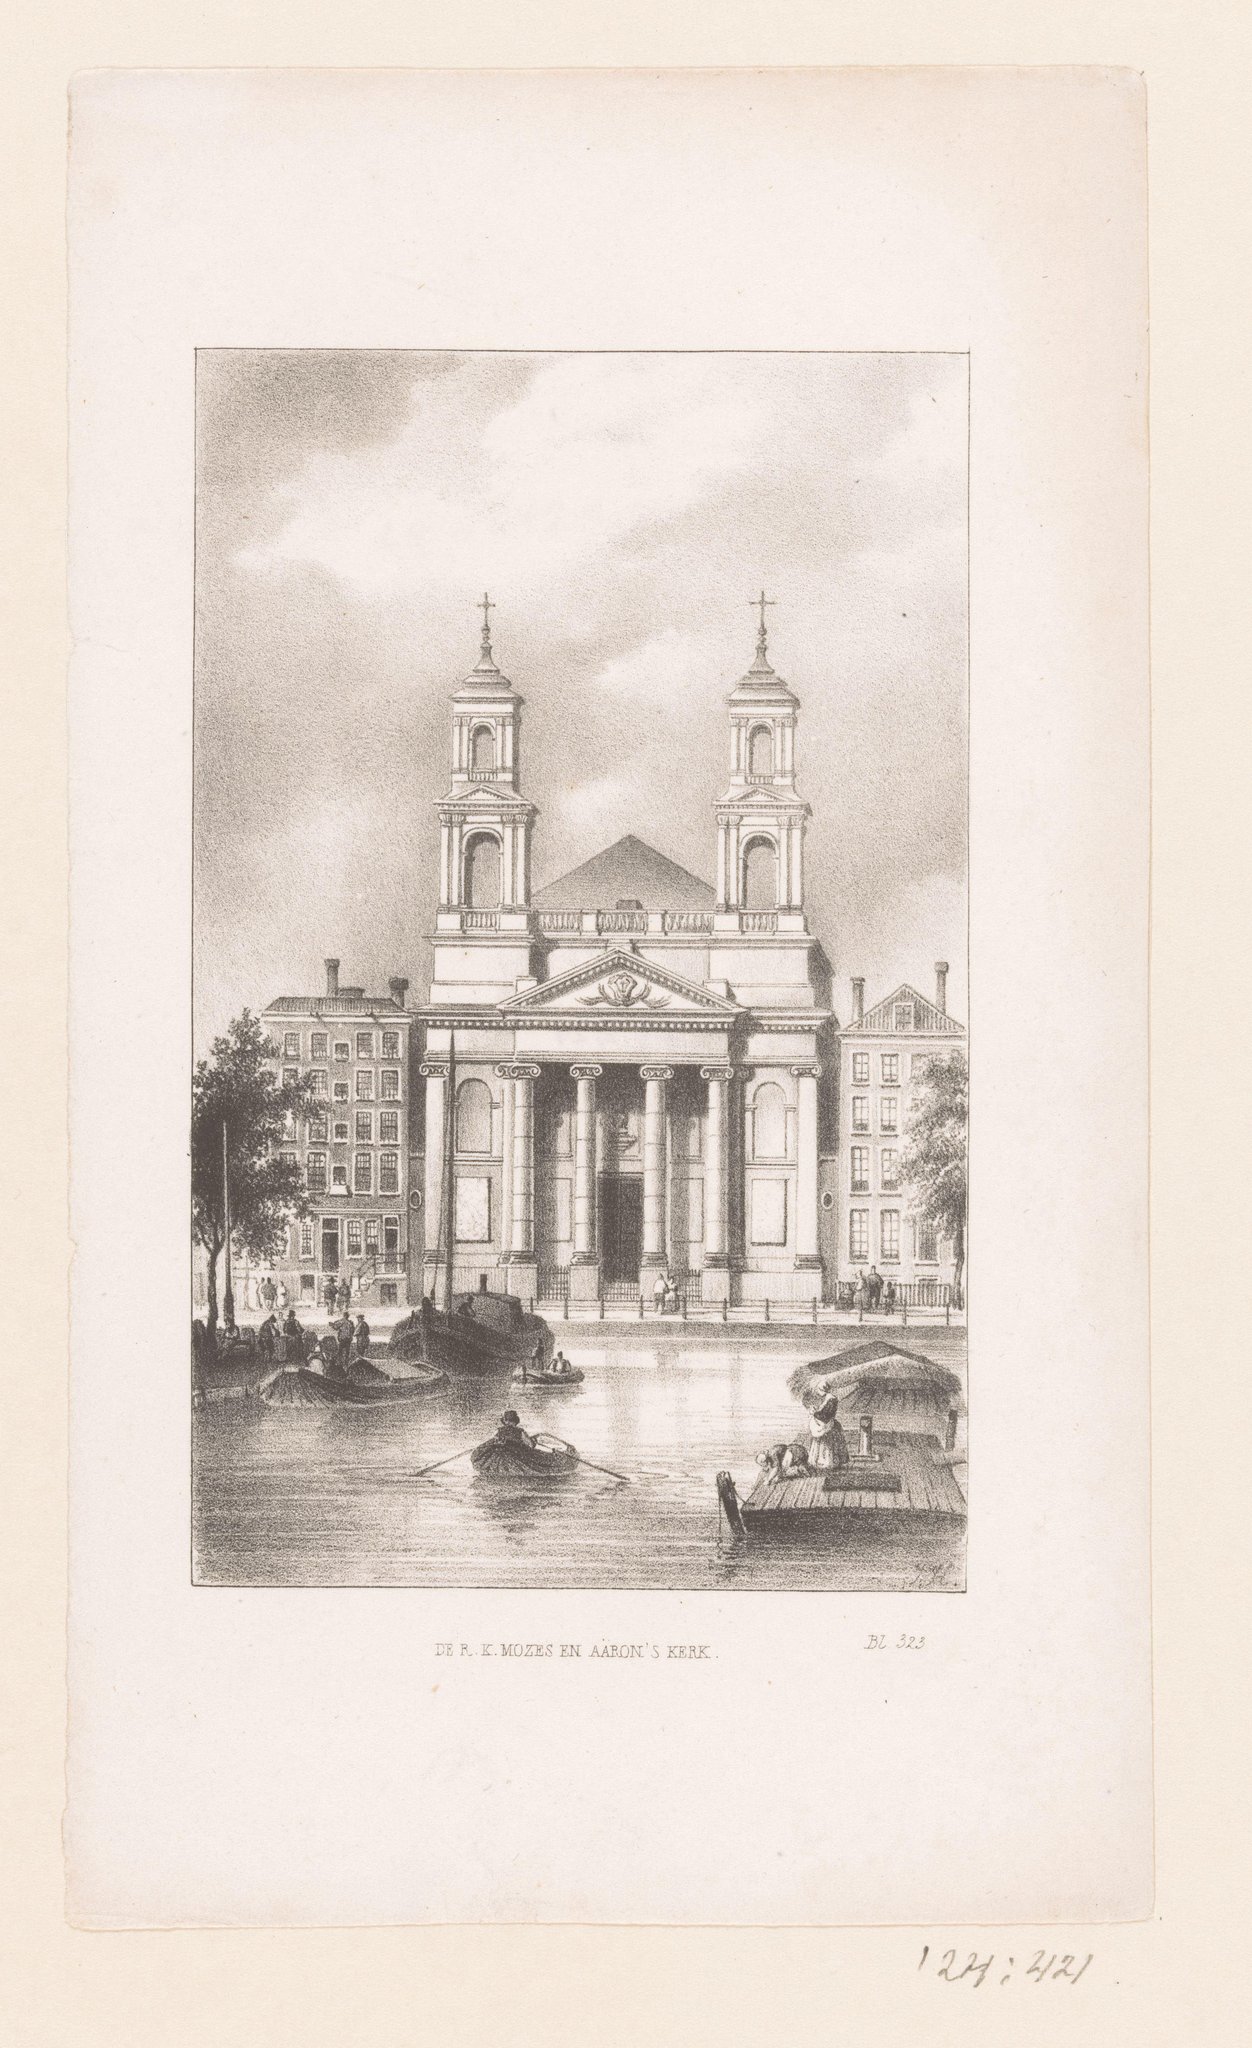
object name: print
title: De R.K. Mozes en Aaron's kerk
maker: monogrammist jh (nederland)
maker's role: print maker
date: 1825-1875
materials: paper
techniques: lithograph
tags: roman catholic church